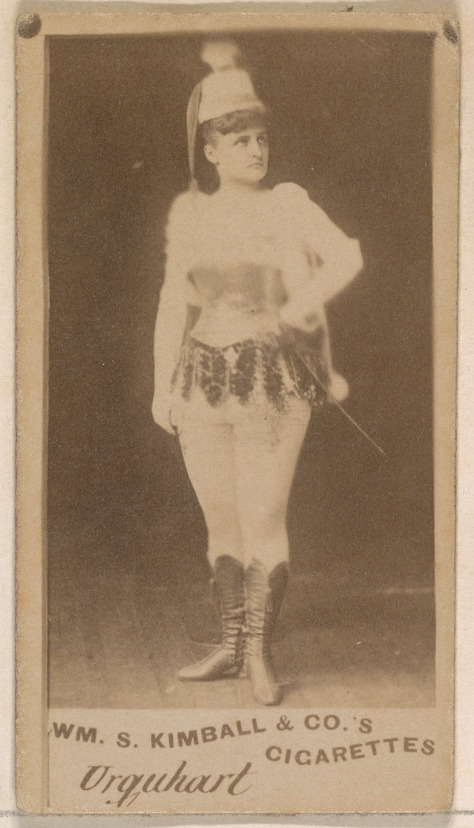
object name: photograph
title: Miss Urquhart, from the Actresses series (N203) issued by Wm. S. Kimball & Co.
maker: william s. kimball & company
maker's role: publisher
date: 1889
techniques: color lithograph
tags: portraits,women,actresses